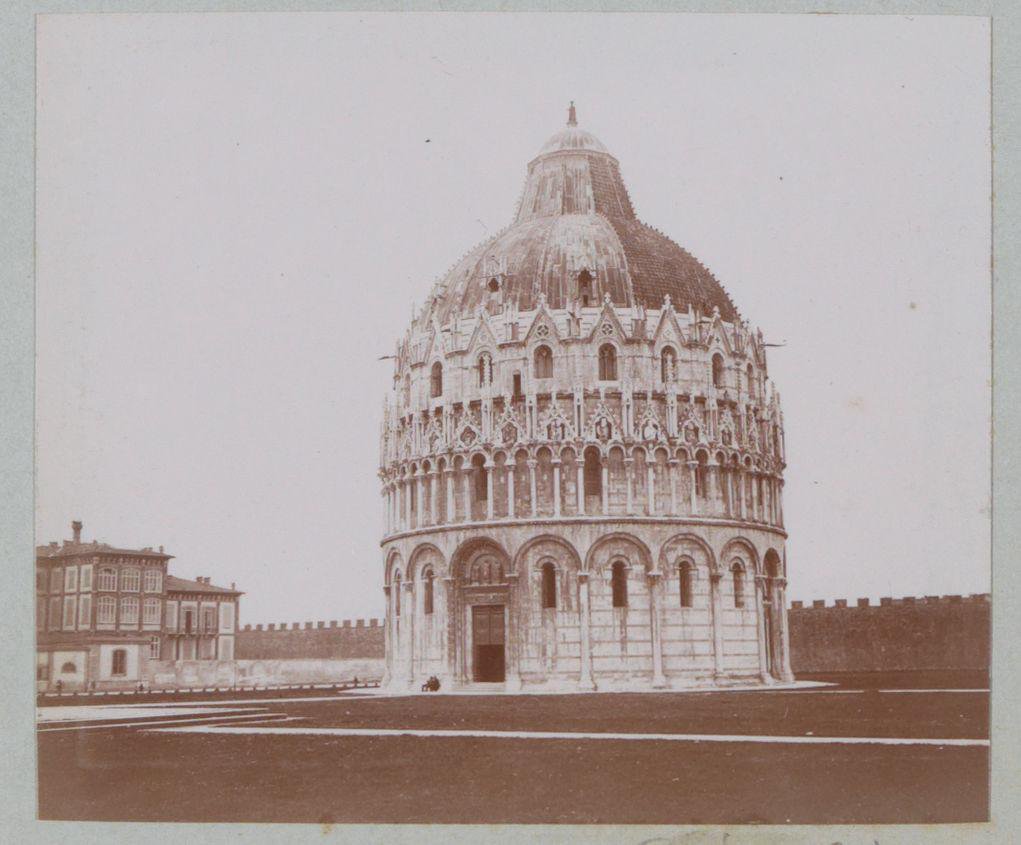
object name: photograph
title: Exterieur van het Baptisterium in Pisa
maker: Anonymous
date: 1905-1910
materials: paper, photographic support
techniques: gelatin silver print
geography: pisa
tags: church (exterior), dome ~ architecture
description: Onderdeel van Fotoalbum van een Franse amateurfotograaf met bezienswaardigheden in Frankrijk, Zwitserland en Italië.